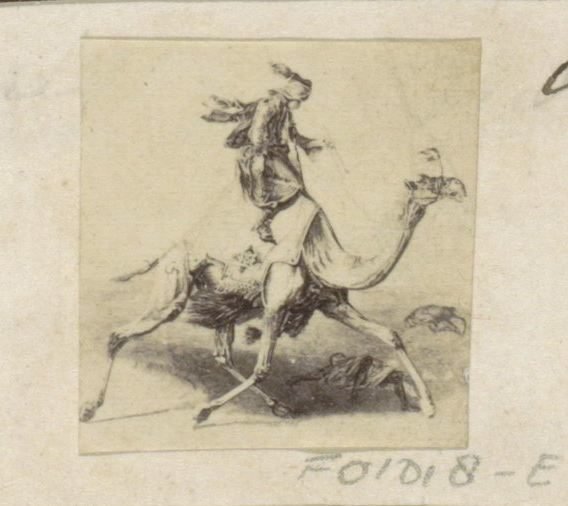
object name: reproduction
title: Fotoreproductie van (vermoedelijk) een prent van een man op een dromedaris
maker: Anonymous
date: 1860-1870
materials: paper, photographic support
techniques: albumen print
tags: hoofed animals: dromedary, riding on animal other than horse, ass, or mule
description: Onderdeel van Engels familiealbum met foto's van personen, reizen, cricket en kunstwerken.